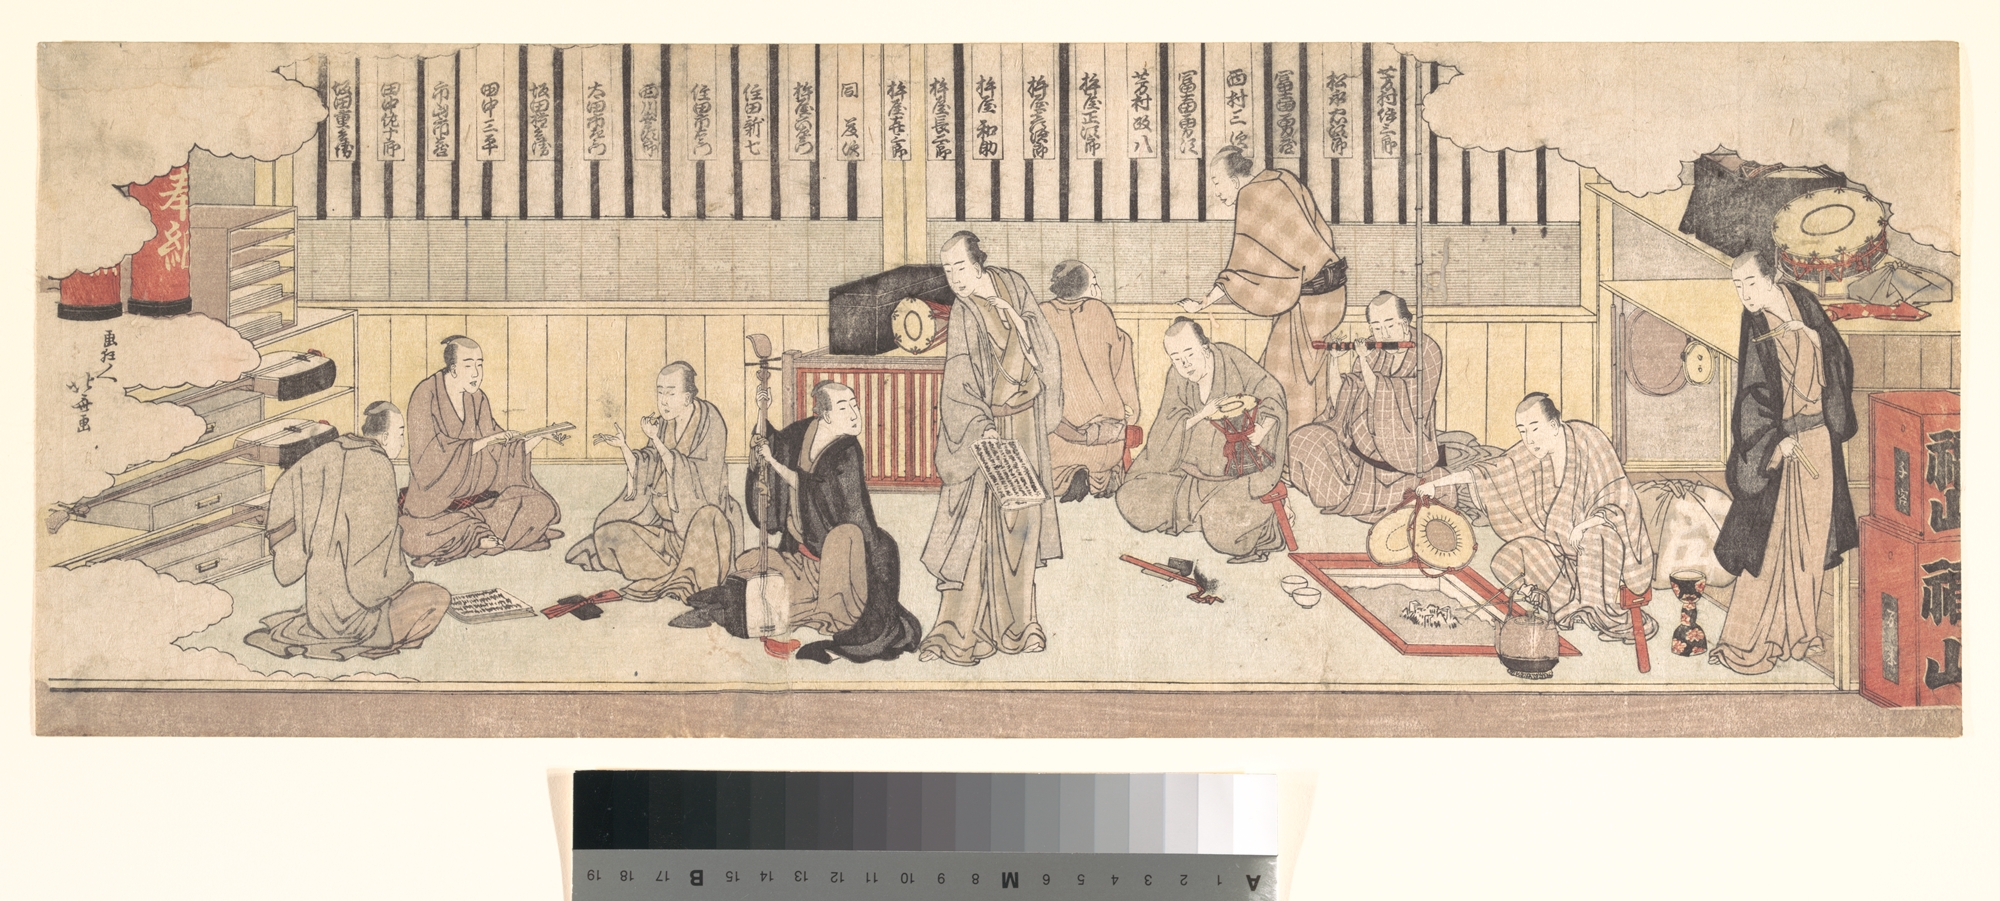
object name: print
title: Dressing Room for Musicians at a Theater (Shitakubeya)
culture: japanese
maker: katsushika hokusai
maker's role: artist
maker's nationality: japanese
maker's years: 1760-1849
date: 1760-1849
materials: ink, paper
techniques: woodblock print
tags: musical instruments,men,musicians